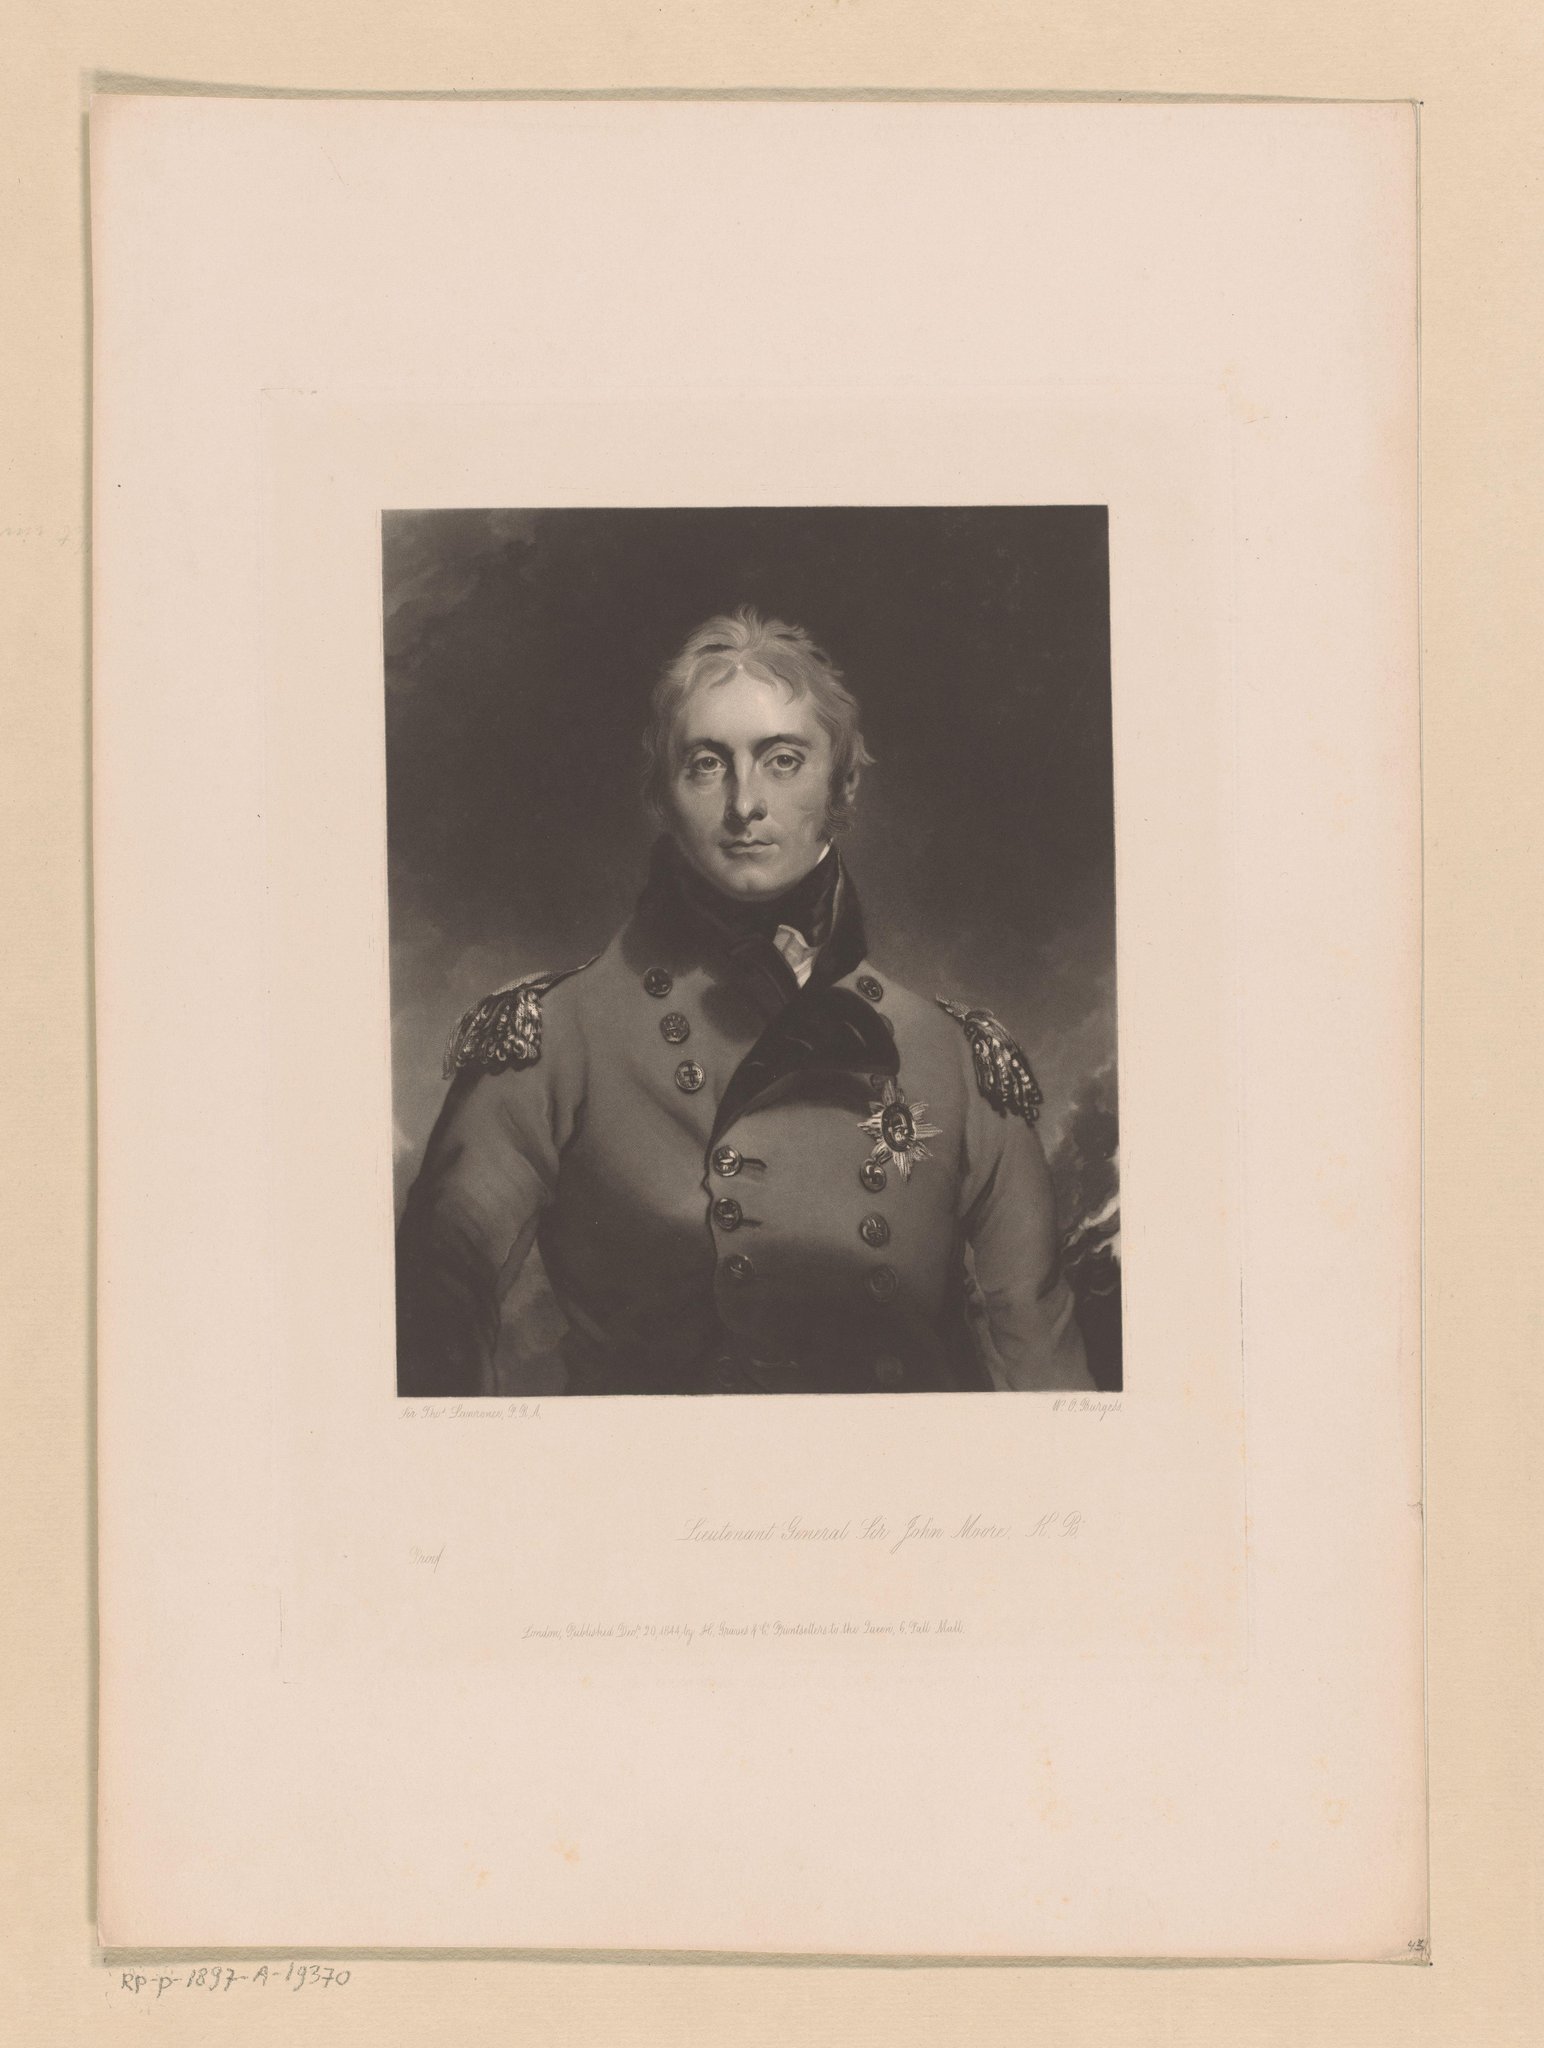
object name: print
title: Portret van John Moore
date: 1840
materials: paper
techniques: mezzotint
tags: glasgow, commander-in-chief, general, marshal, historical persons